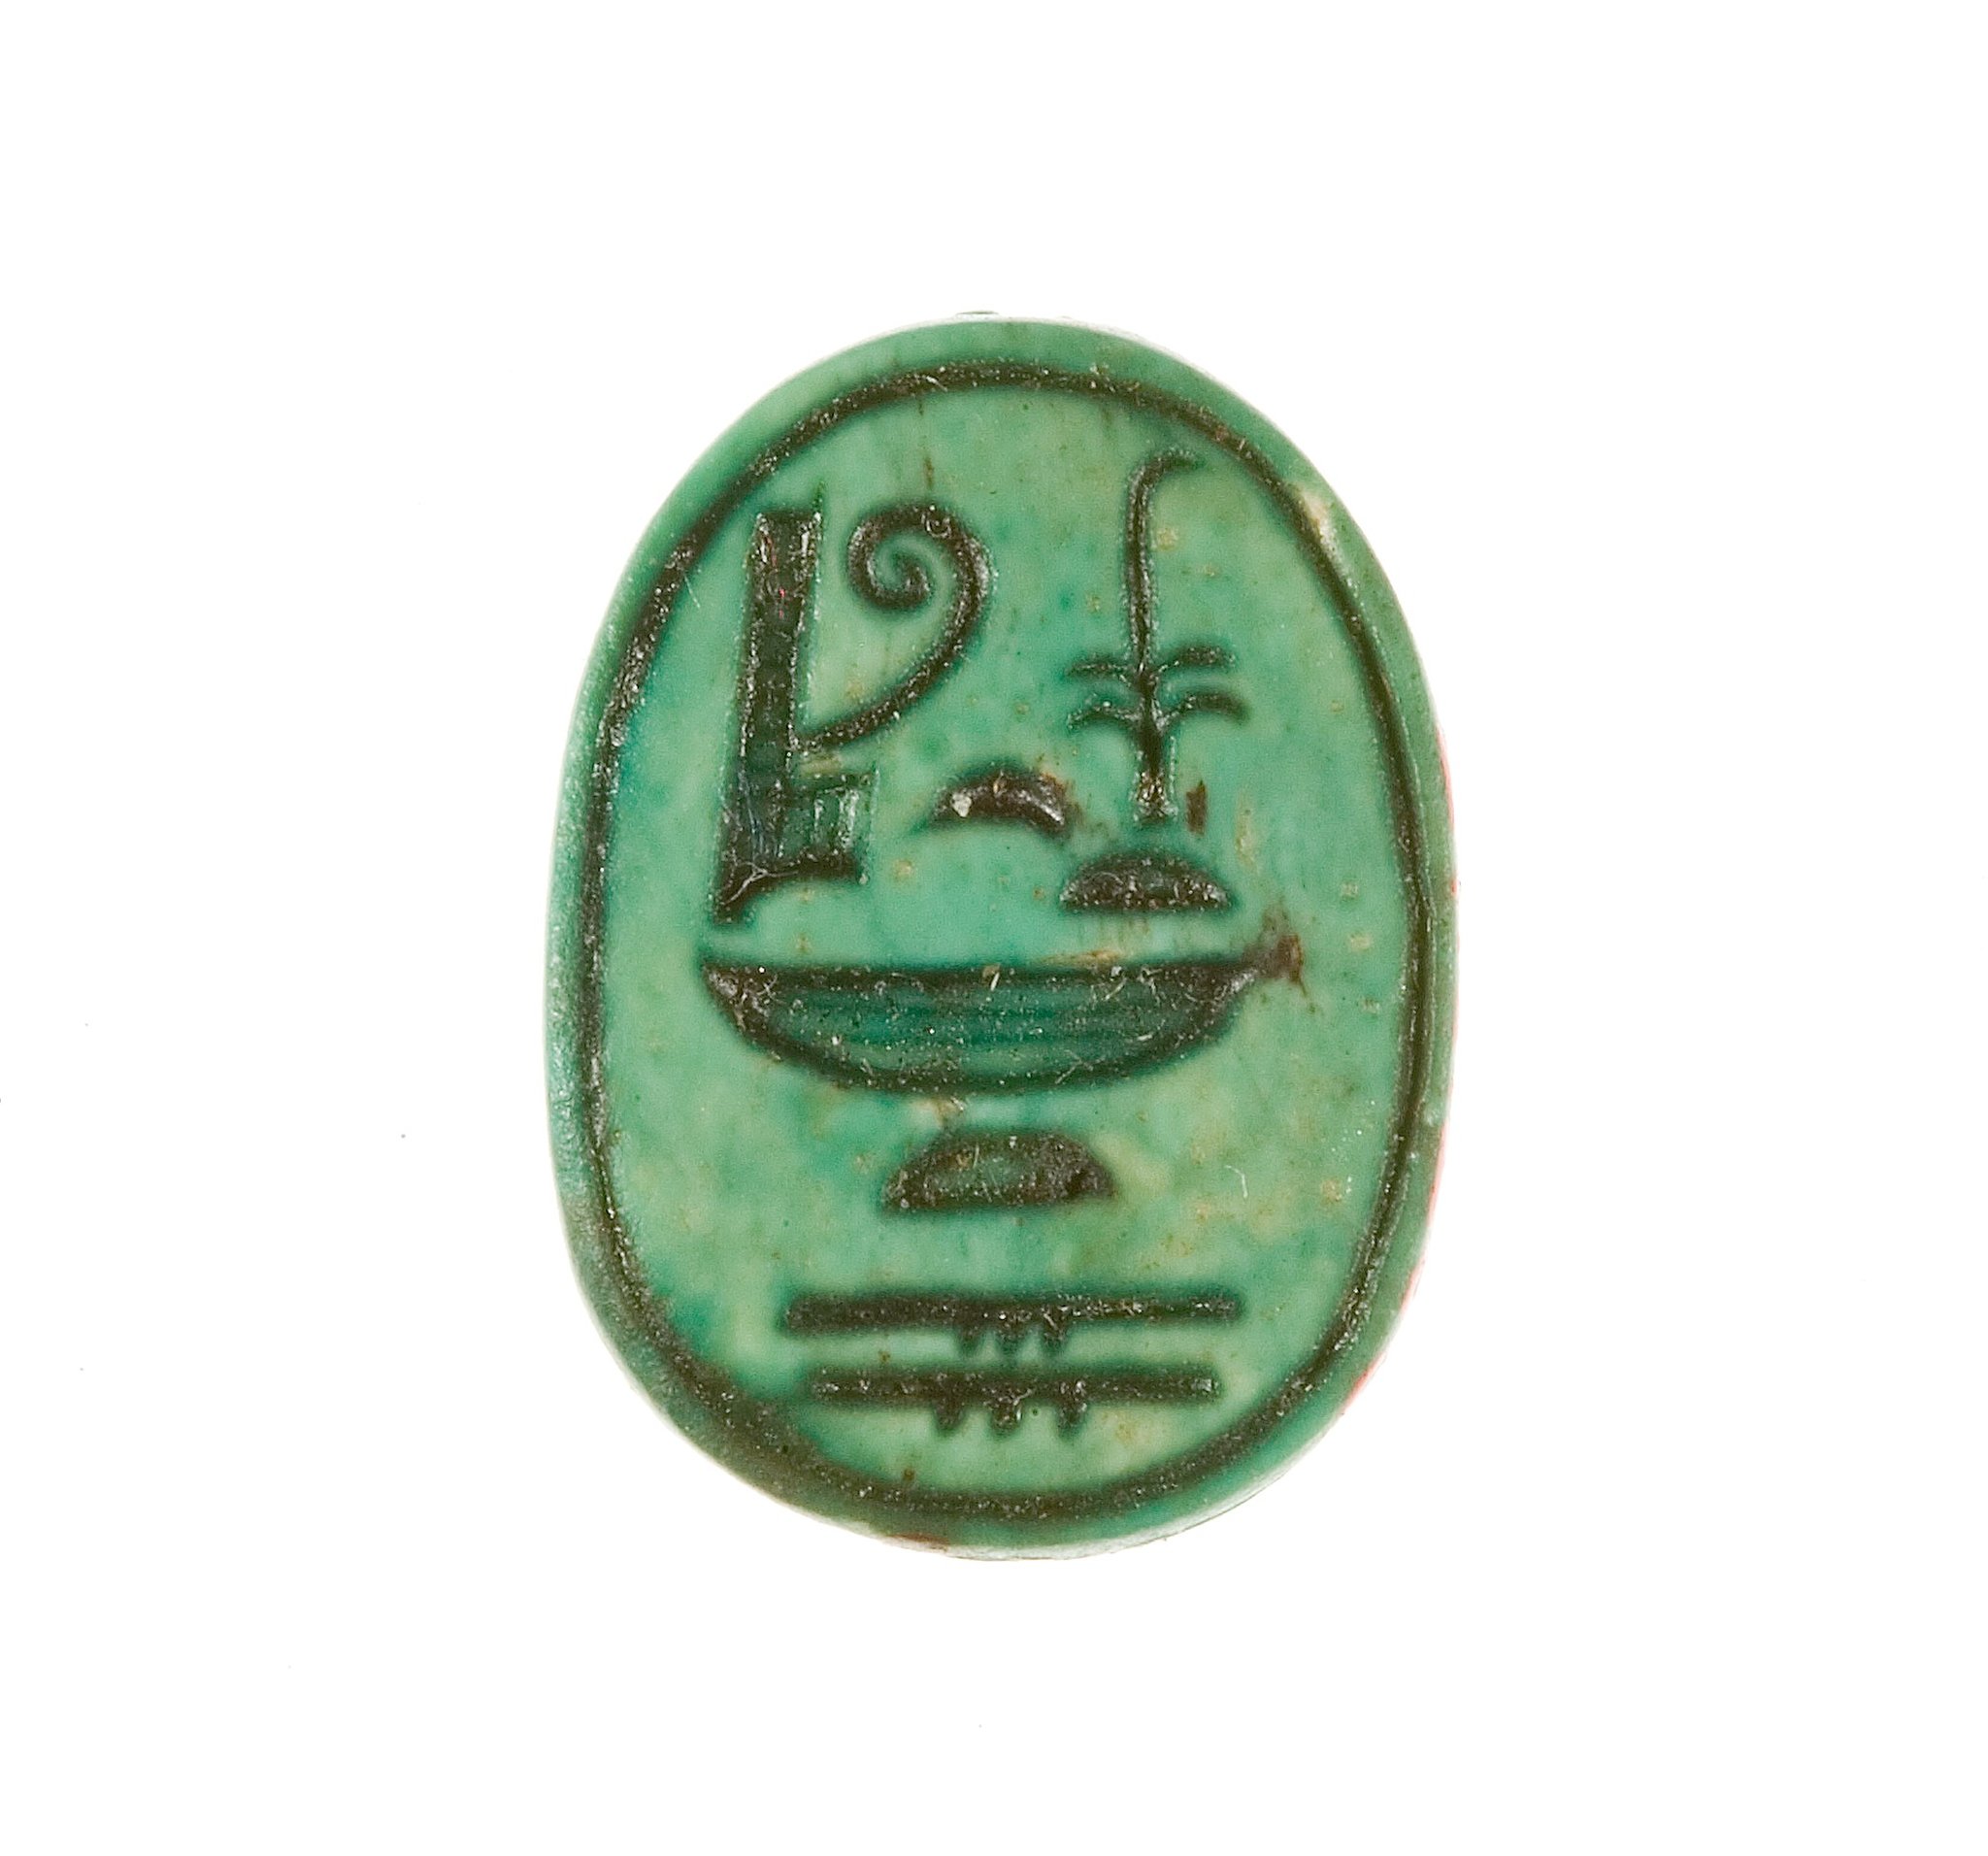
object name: scarab, nswt bity, red crown, lady, two land, notched back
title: Scarab Inscribed King of Upper and Lower Egypt, Lady of the Two Lands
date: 1479-1458 BCE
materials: stone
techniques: glazing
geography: egypt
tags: hieroglyphs,scarabs